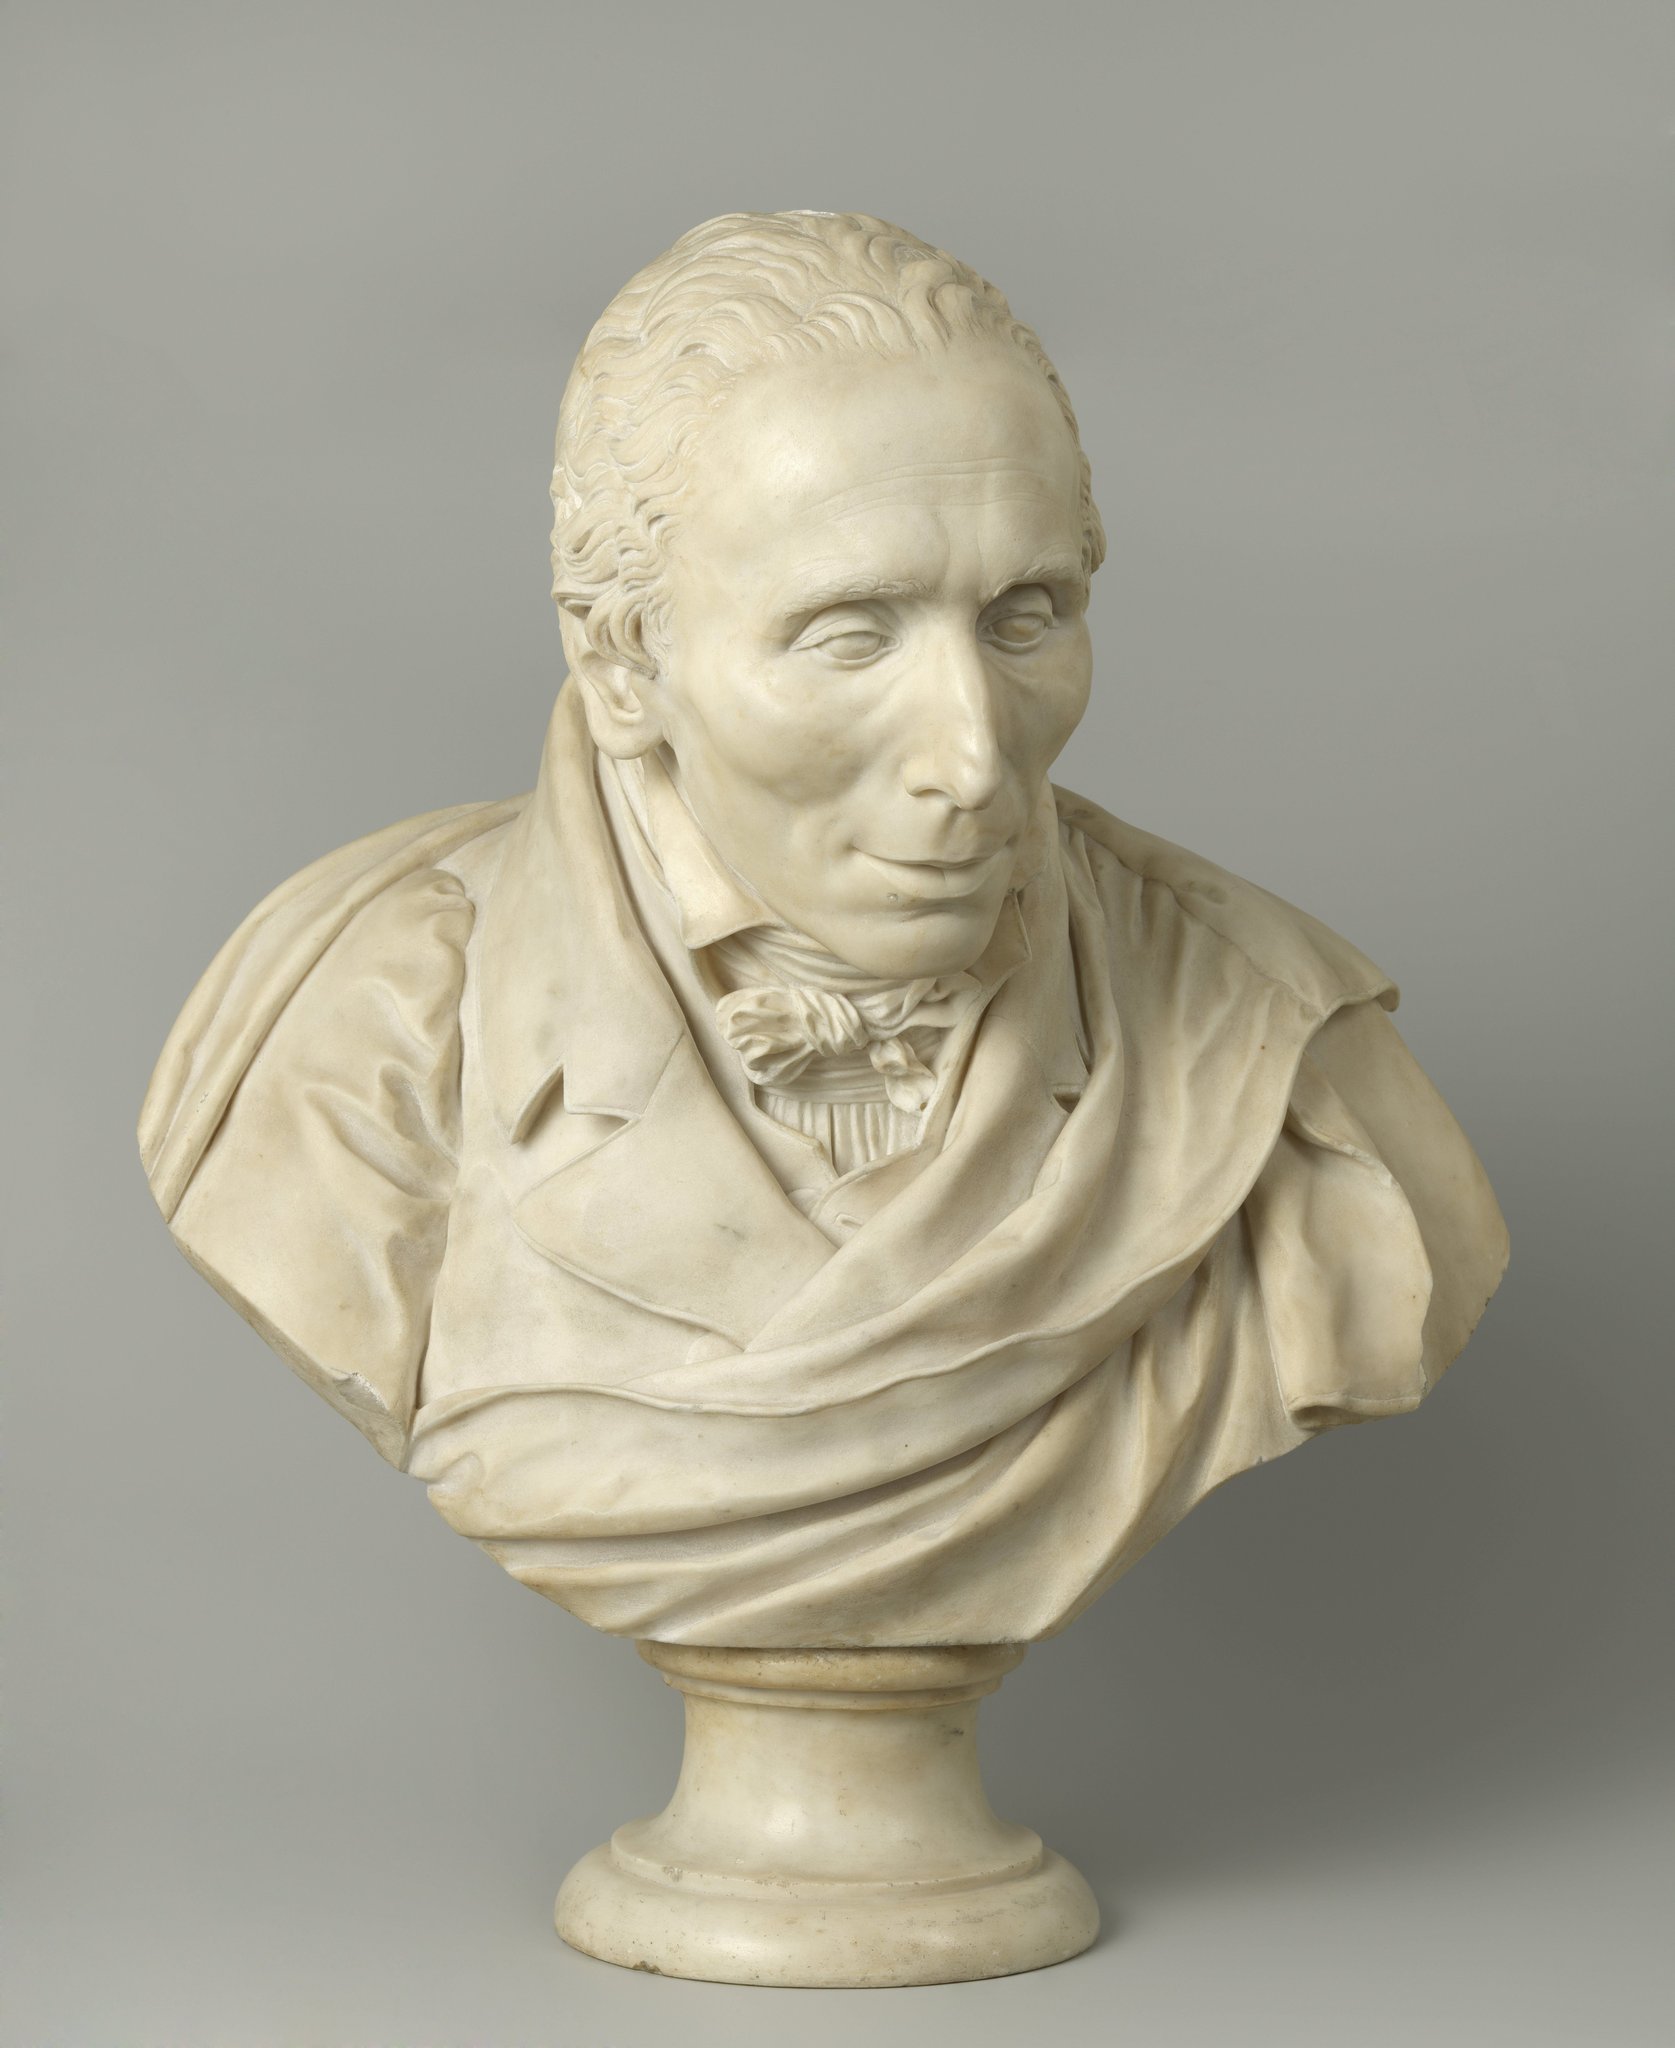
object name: bust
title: Portrait of Antonio Canova (1757-1822)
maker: adamo tadolini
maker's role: sculptor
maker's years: 1788-1868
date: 1822-1825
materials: marble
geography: rome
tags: venice, painter, draughtsman, antonio canova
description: This frail old man is Antonio Canova, the most celebrated sculptor in Europe around 1800, and a model for many of Rome’s young artists. Despite its lifelike appearance, the sculpture was made after Canova’s death, based on his death mask. Perhaps it was Adamo Tadolini who made the sculpture; he was one of Canova’s last assistants and may have indented this as a tribute to his former master.